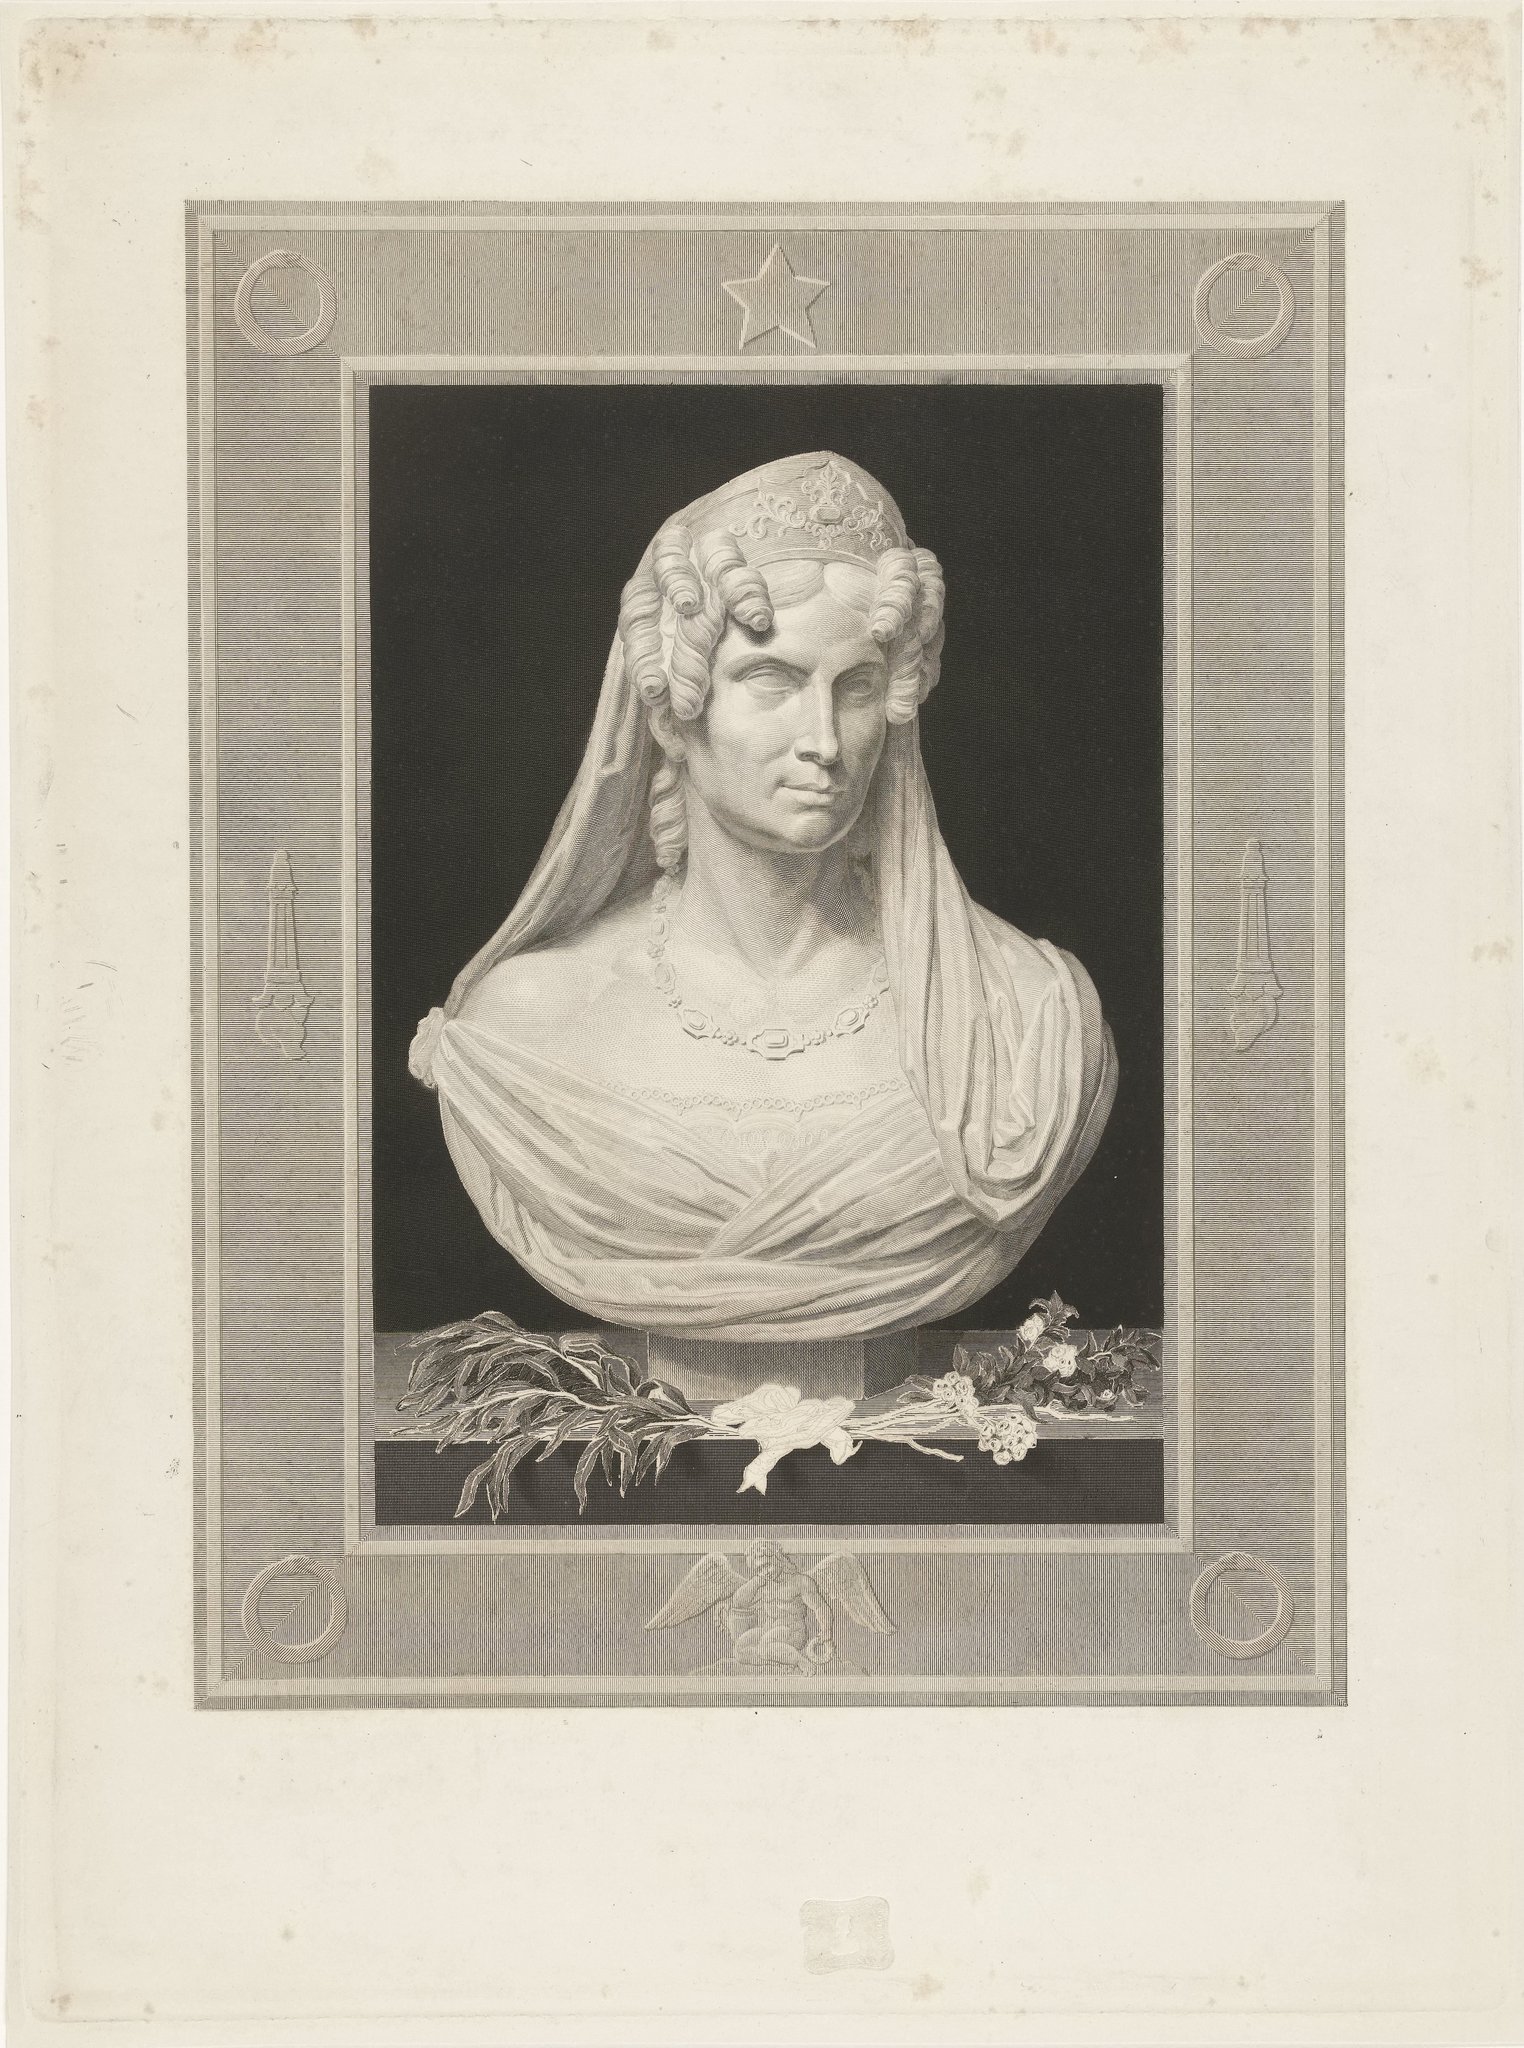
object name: print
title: Portretbuste van Anna Poulowna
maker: henricus wilhelmus couwenberg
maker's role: draughtsman, print maker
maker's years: 1814-1845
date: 1838-1840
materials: paper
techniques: engraving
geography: amsterdam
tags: berlin, the hague, wilhelmina frederica louisa (koningin der nederlanden), piece of sculpture, reproduction of a piece of sculpture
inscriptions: collector's mark: Lugt 2228, check stamp: ‘Maatsch tot Bev van Beeld Kunsten’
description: Twee ontwerptekeningen voor de prent aanwezig in de collectie, inv.nr. RP-T-1912-22, RP-T-1912-21. De marmeren buste van Louis Royer bevindt zich in de Koninklijke Verzamelingen, Den Haag; https://koninklijkeverzamelingen.nl/collectie-online/objects/24501